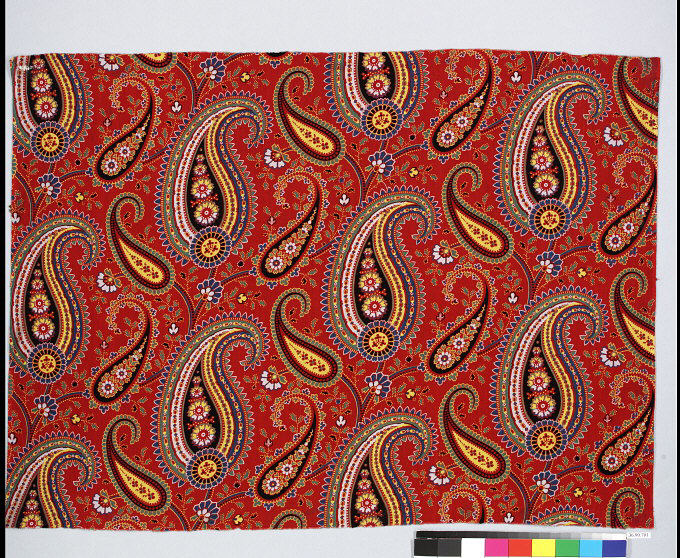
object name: piece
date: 1867-1900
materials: cotton